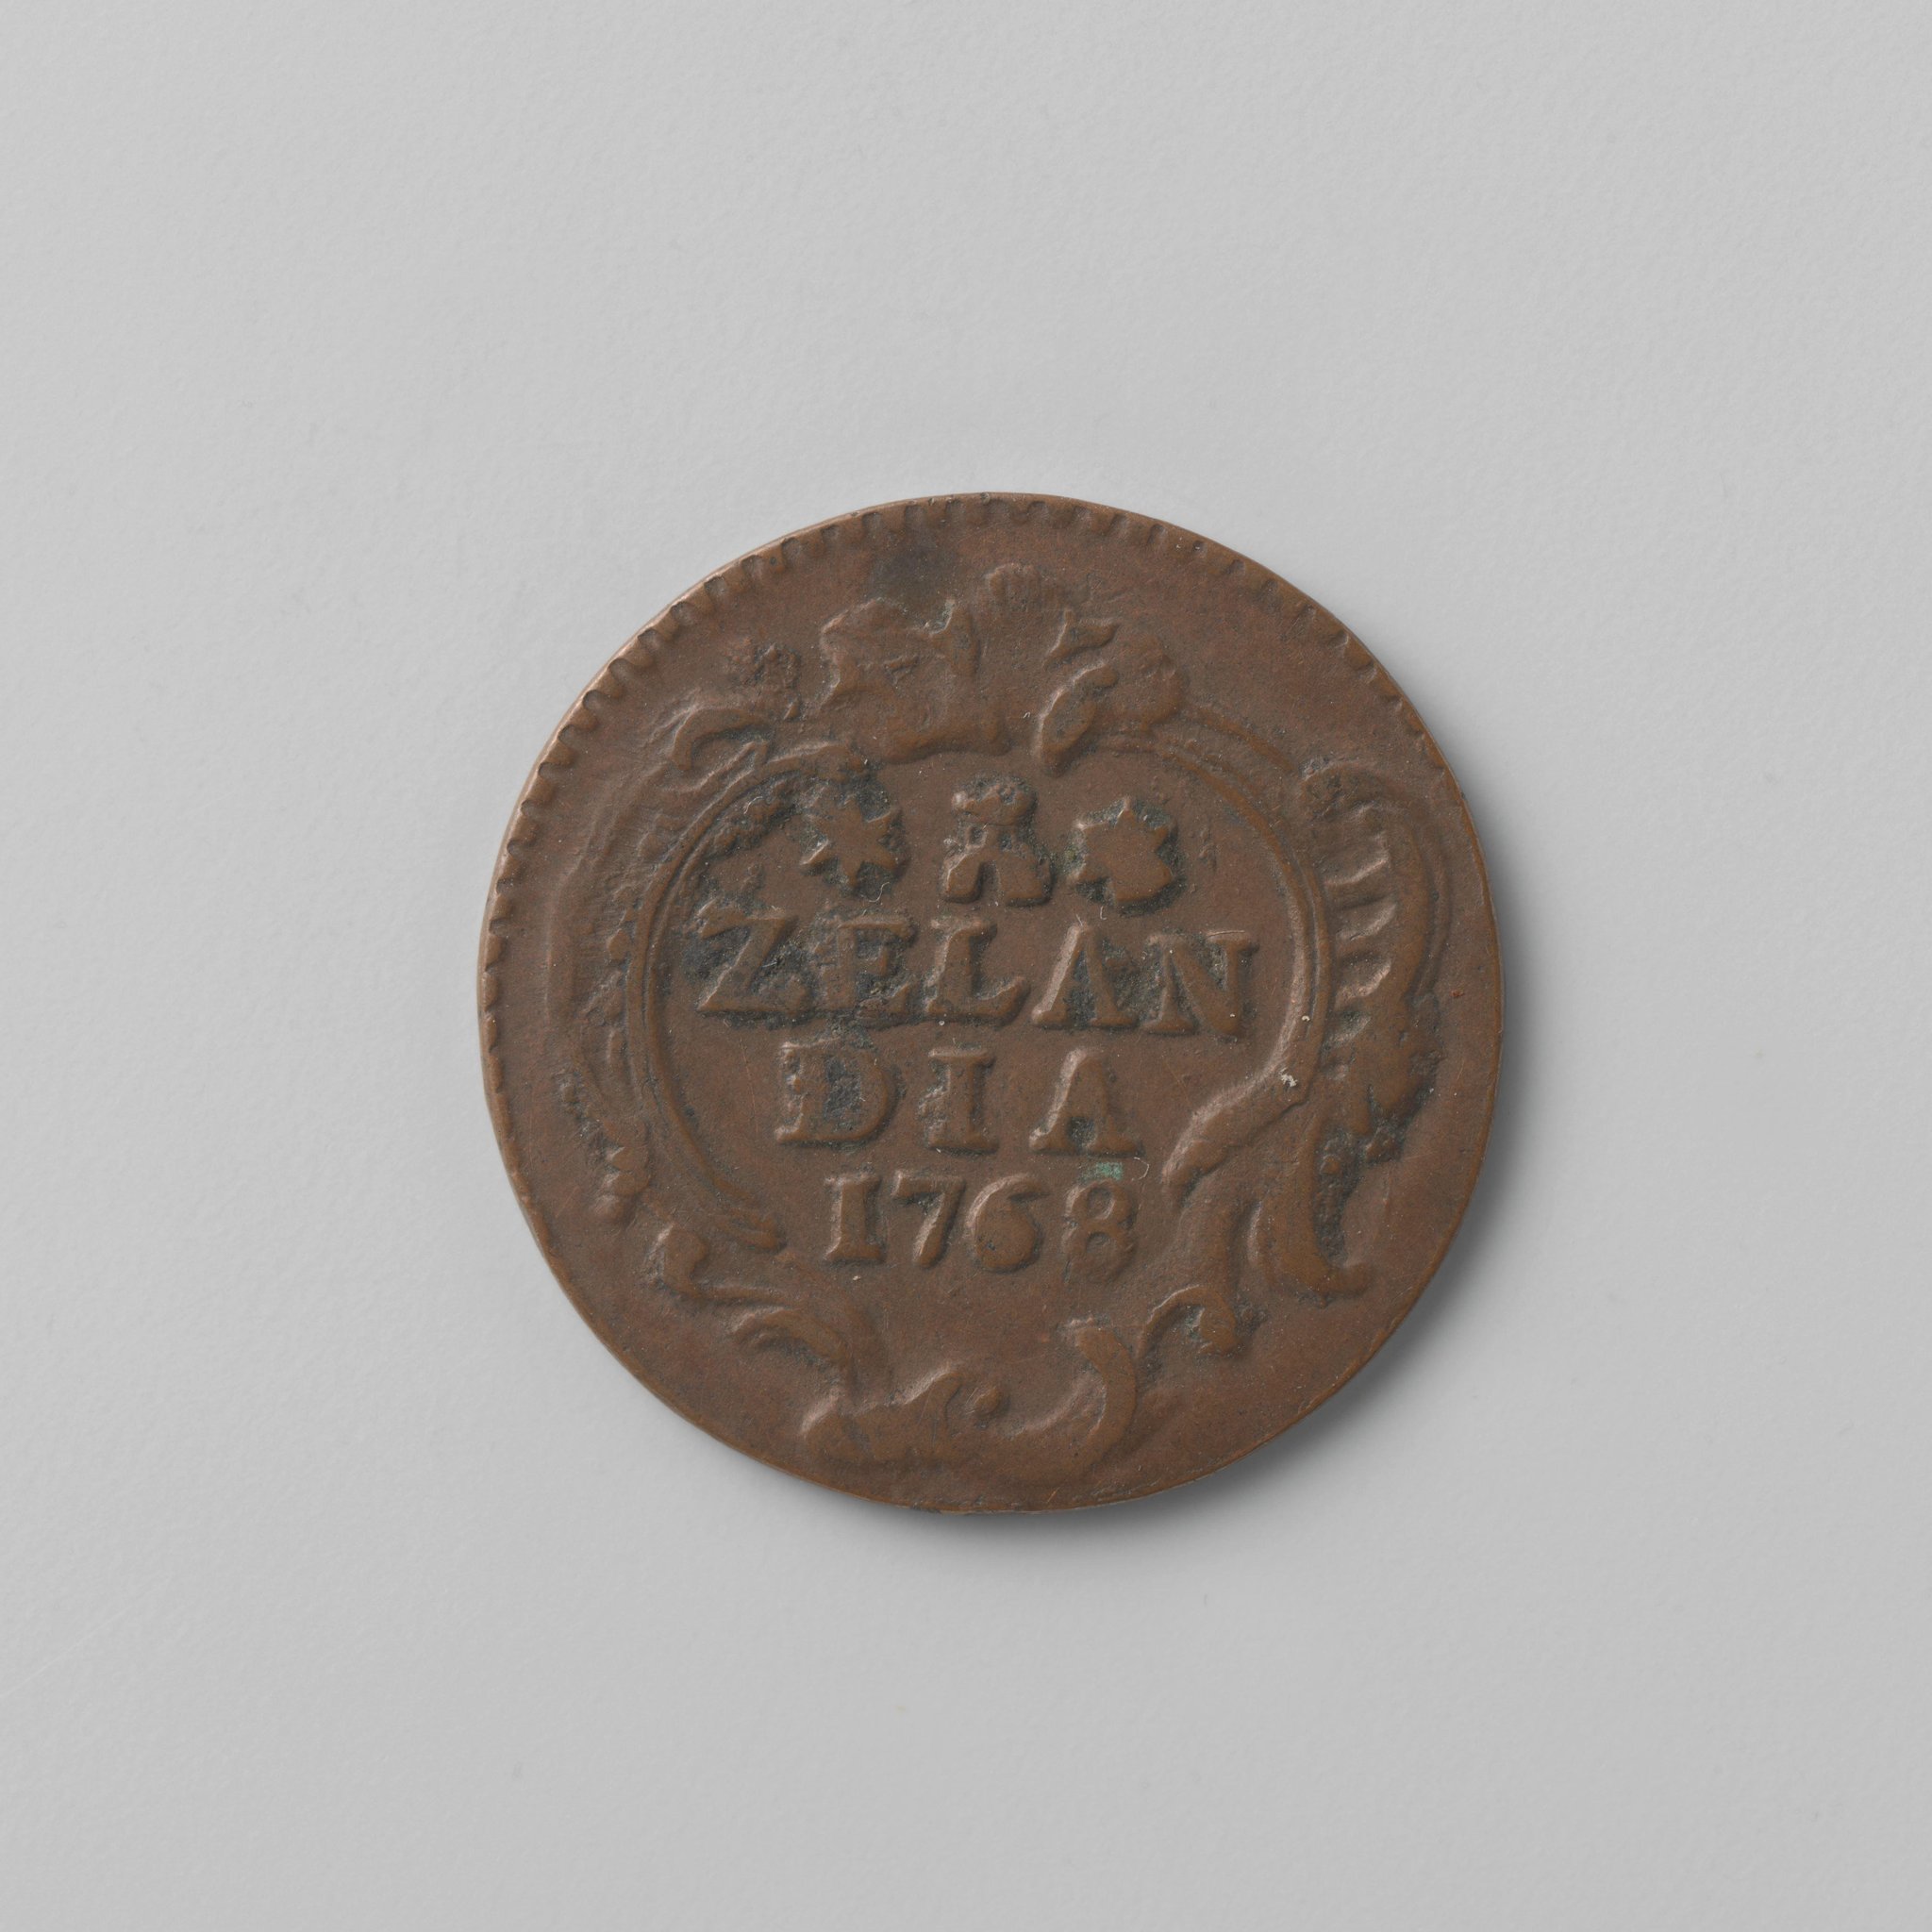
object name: coin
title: Zeeuwse duit, 1768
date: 1768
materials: copper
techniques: striking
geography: middelburg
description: Koperen munt. Voorzijde: in rococo-lijst gekroond ovaal wapenschild van Zeeland. Keerzijde: in een rococo-versiering opschrift in drie regels, waarboven muntteken burcht tussen twee sterren en waaronder jaartal.